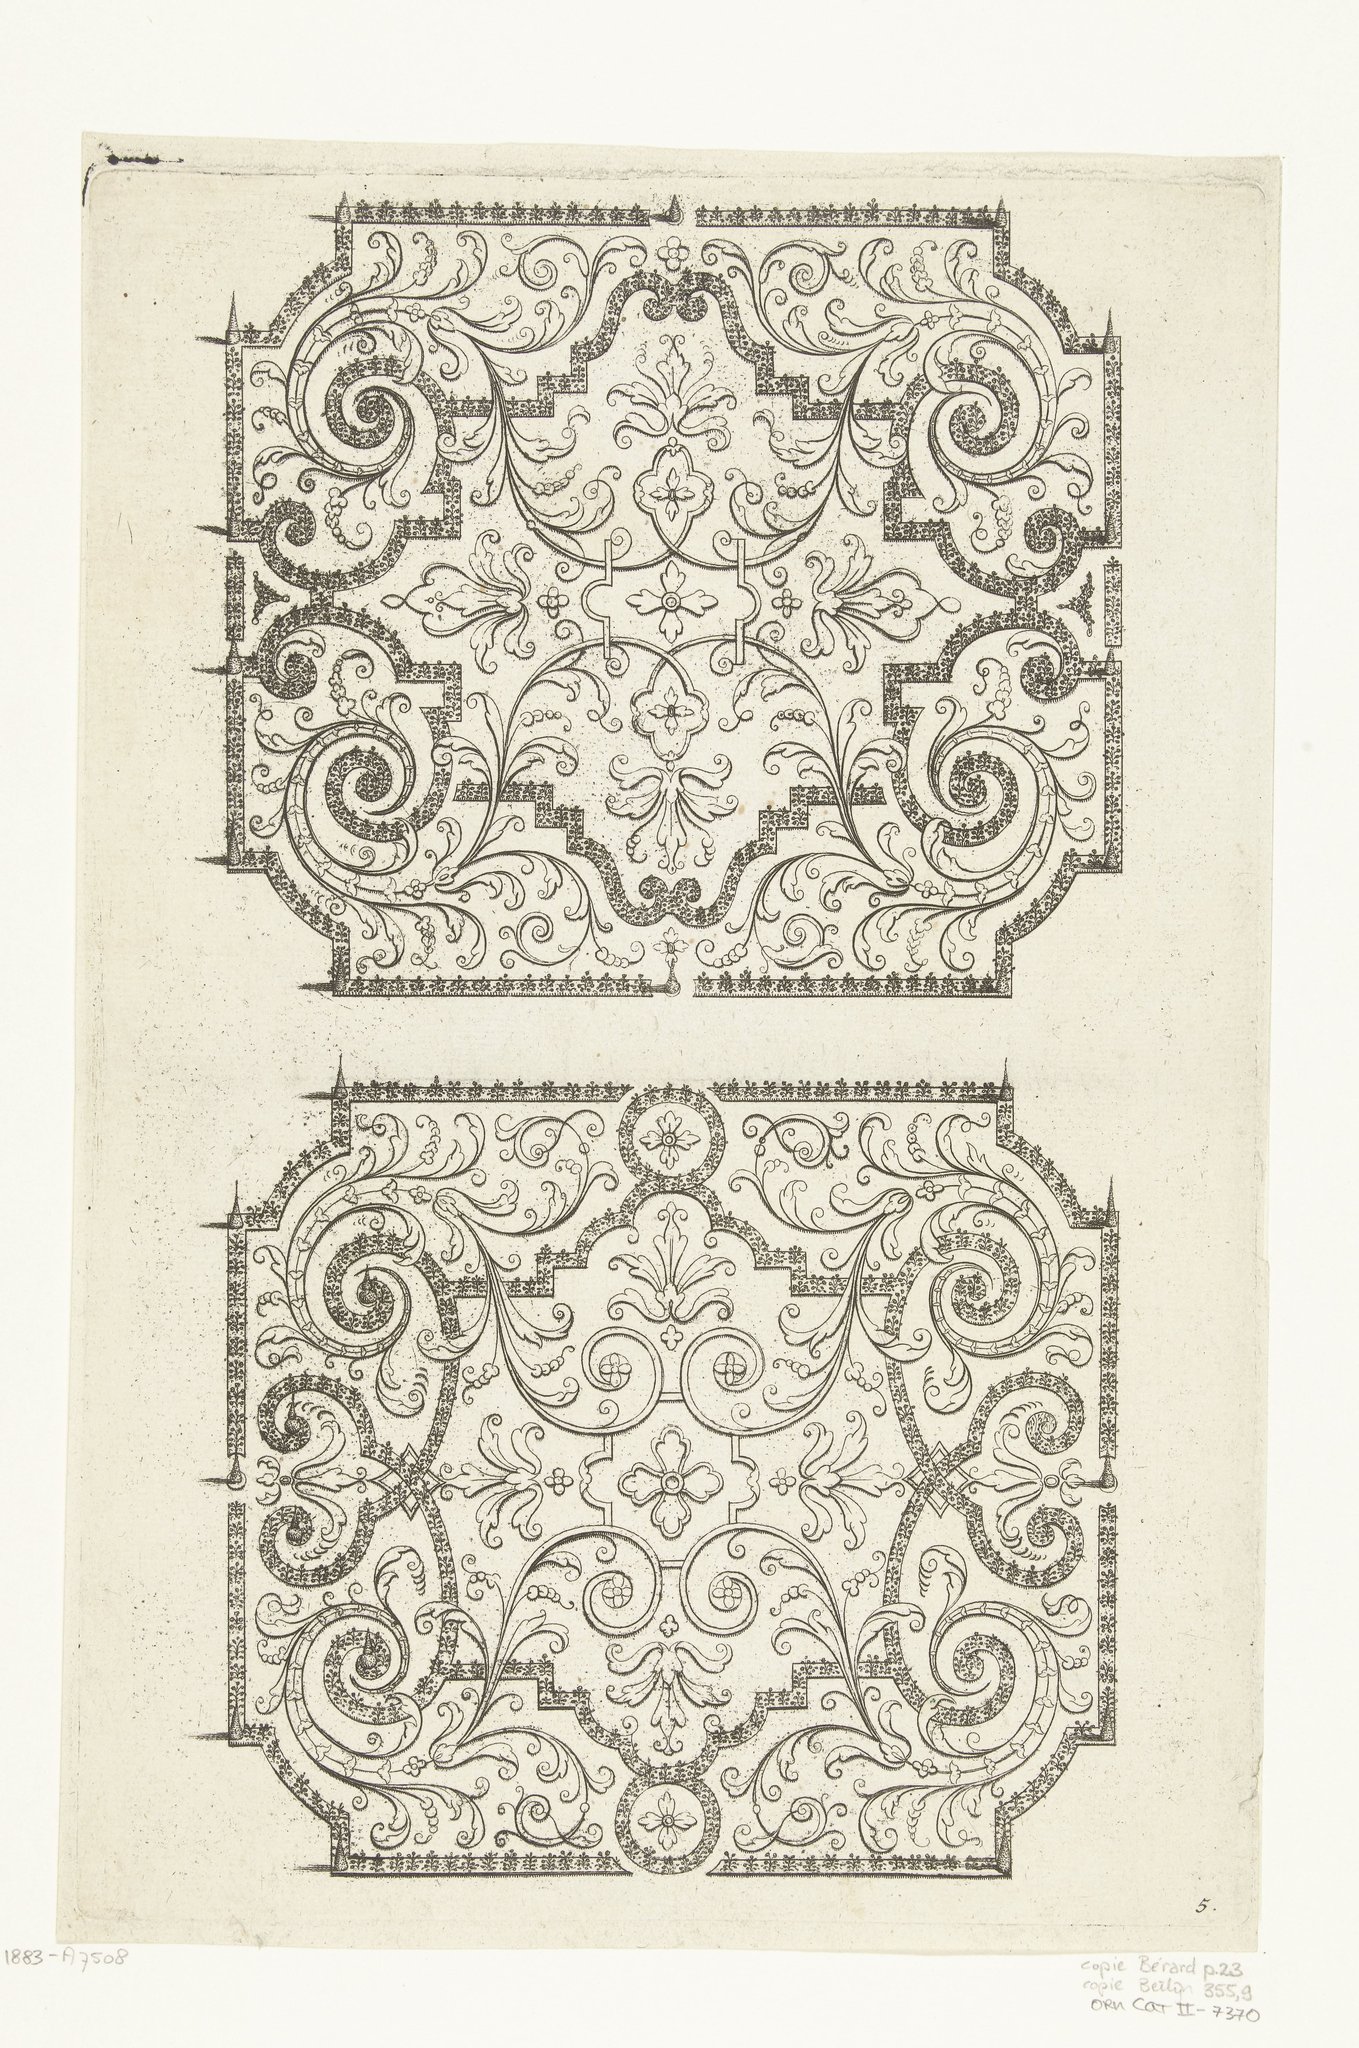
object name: print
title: Plan van tuin met twee rechthoekige parterres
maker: Anonymous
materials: paper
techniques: etching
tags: lay-out of garden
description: De parterres hebben afgesneden hoeken. Blad uit serie ontwerpen voor tuinen met parterres.